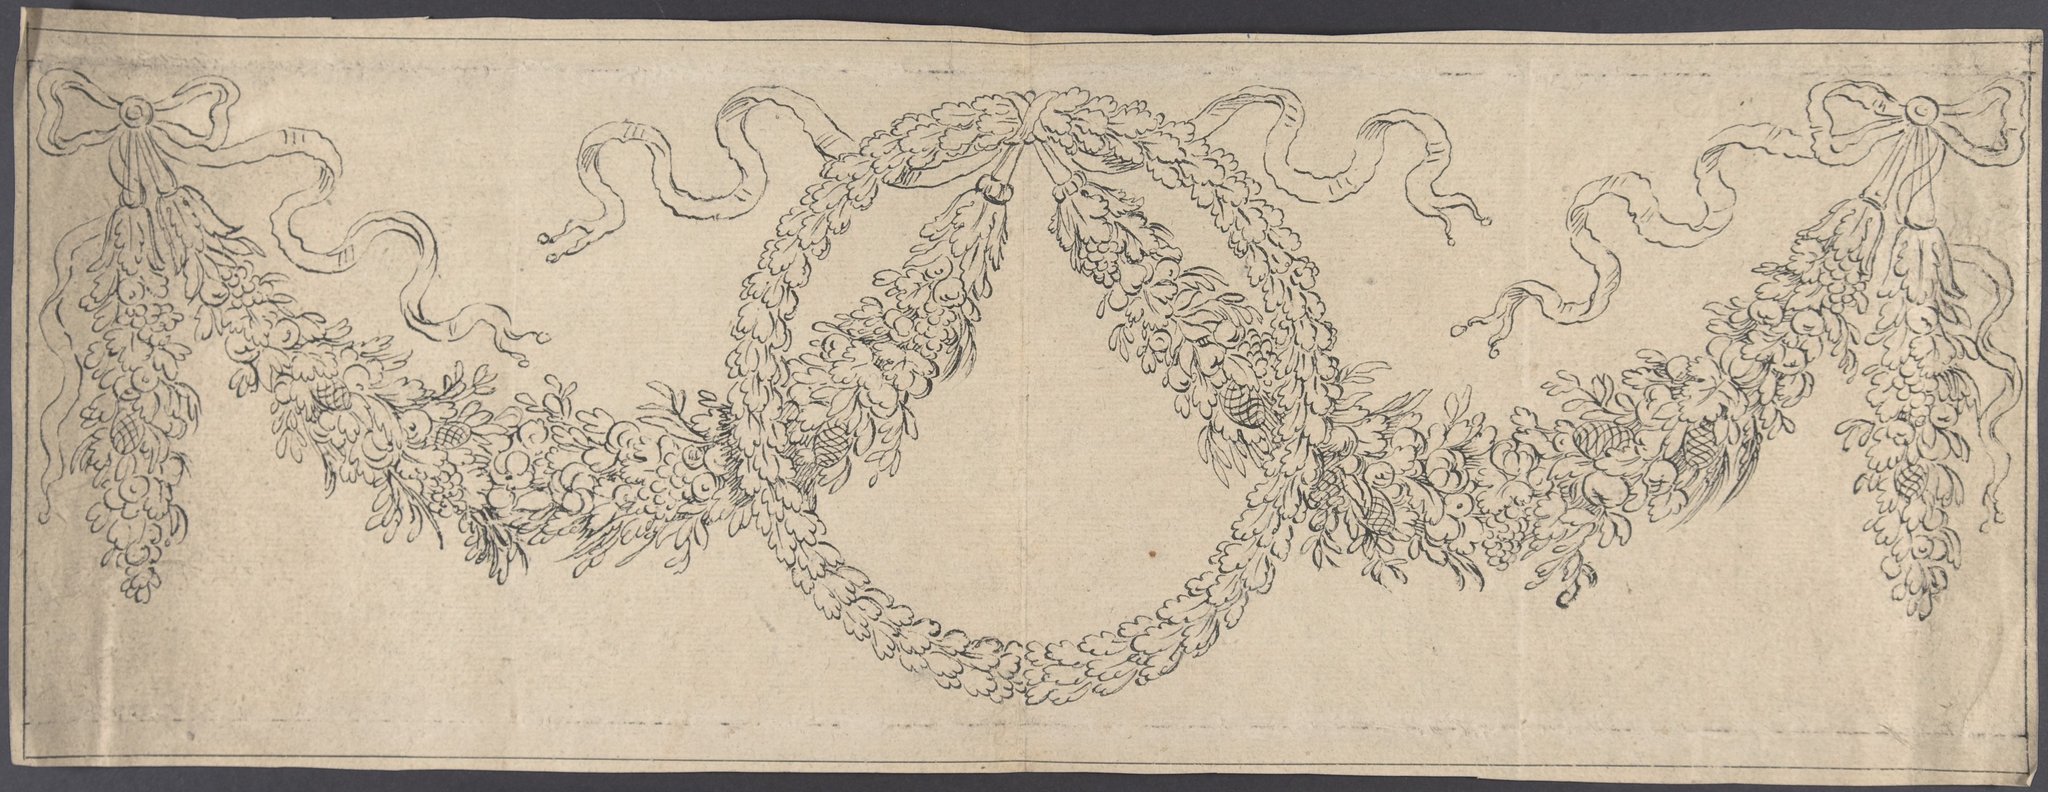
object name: drawing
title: Design for a Frieze with Wreath and Festoons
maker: anonymous, british, 18th century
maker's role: artist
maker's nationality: british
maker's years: 1700-1800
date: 1701-1800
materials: ink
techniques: pen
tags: garlands,wreaths